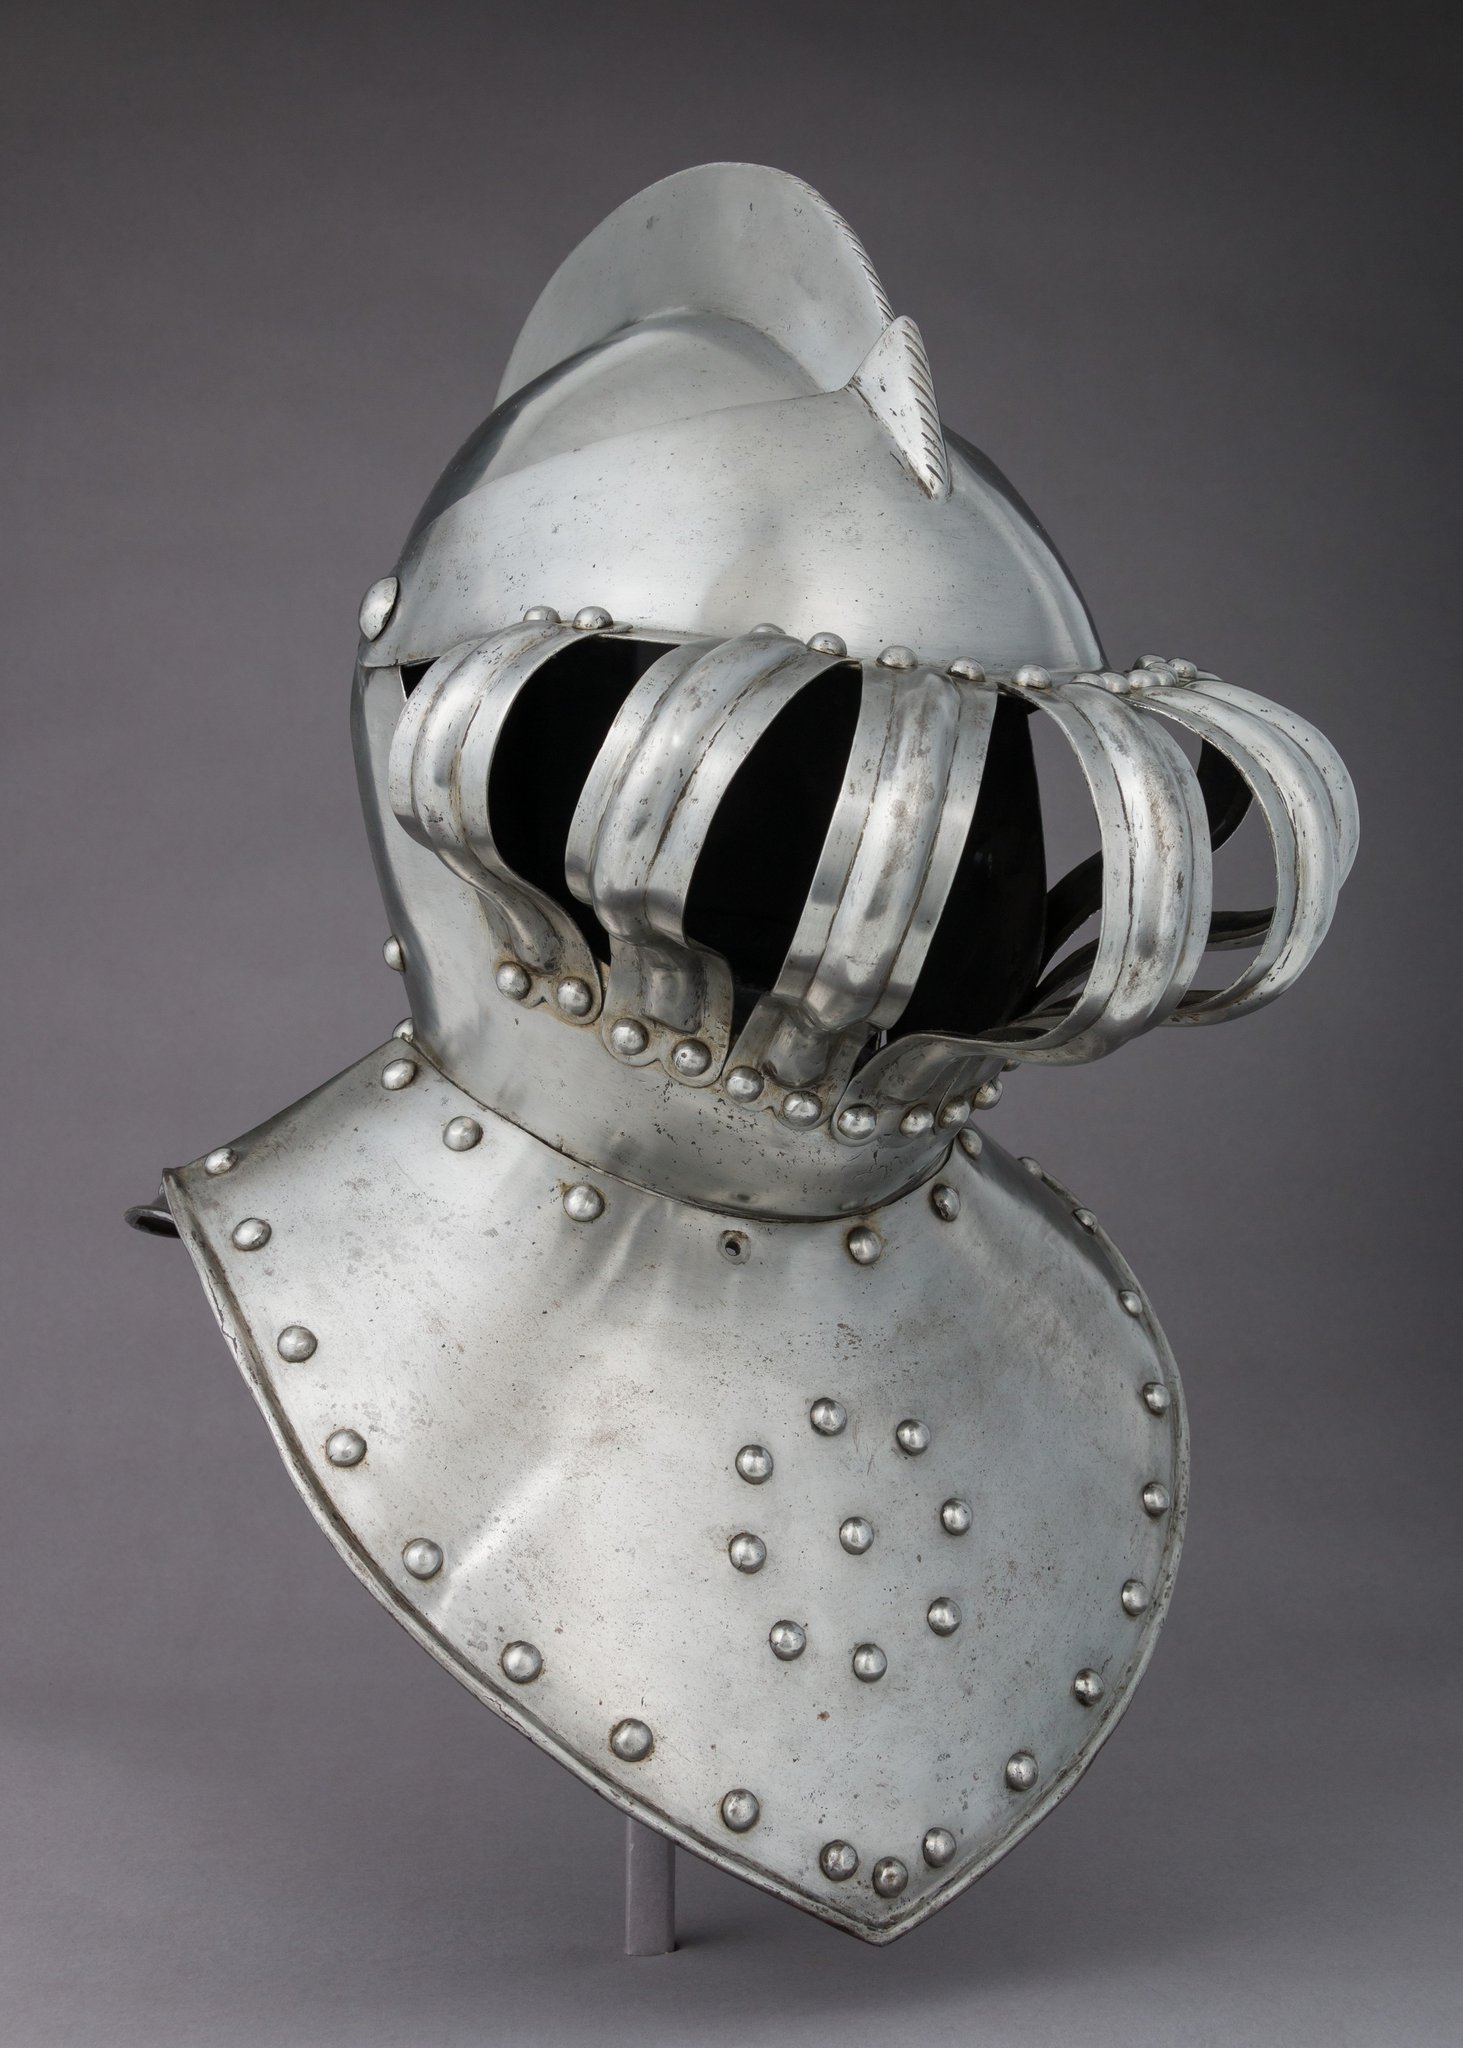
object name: burgonet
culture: german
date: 1601-1700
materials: leather, steel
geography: germany